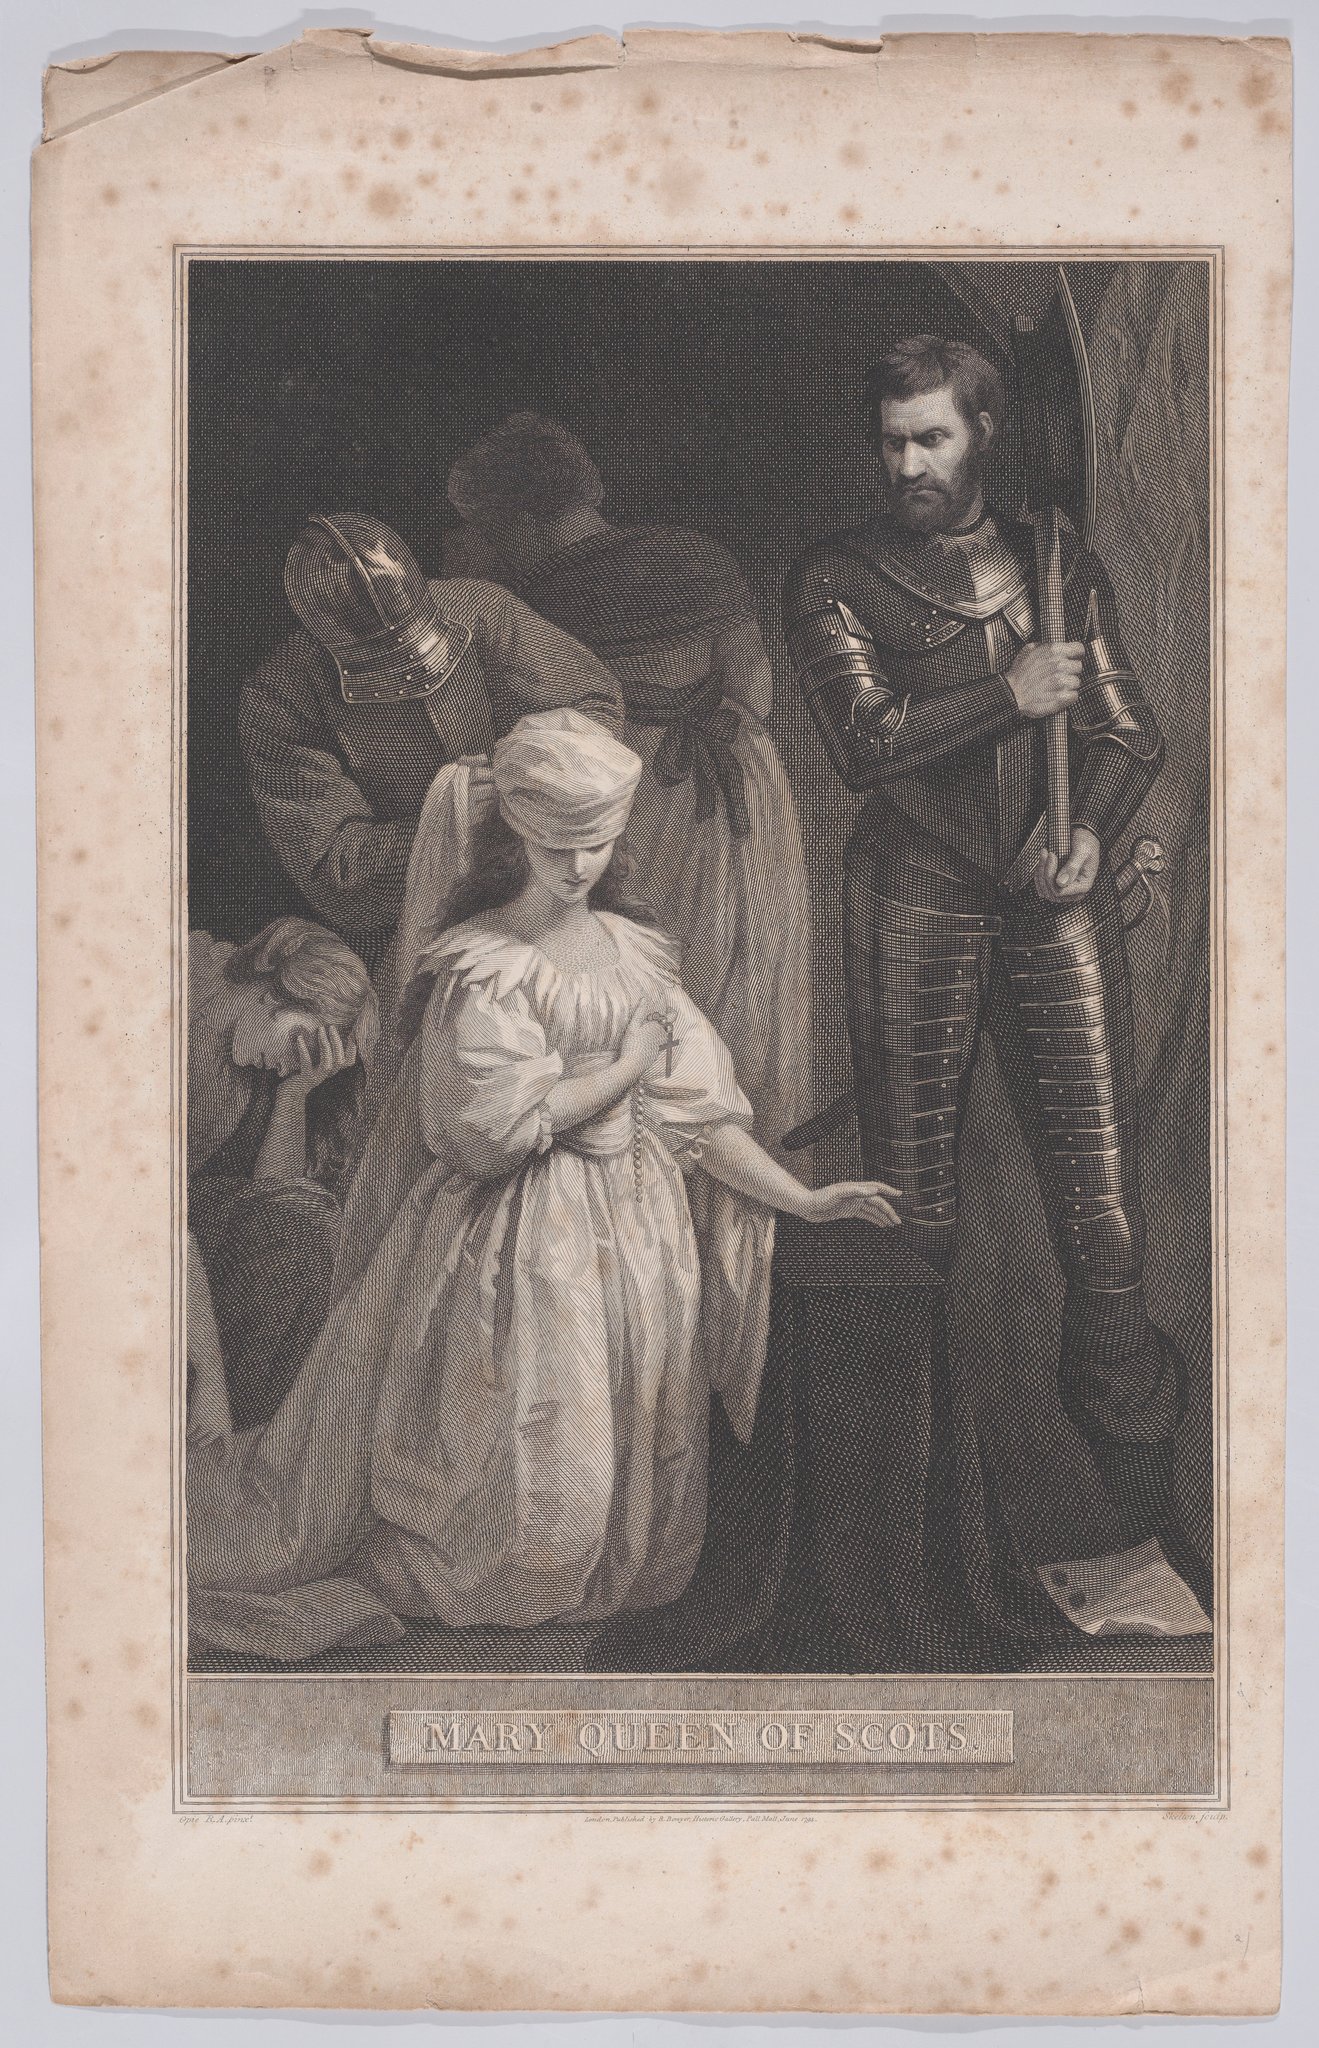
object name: print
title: Mary, Queen of Scots at the execution block (from "The History of England")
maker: david hume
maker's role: author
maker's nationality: british, scottish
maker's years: 1711-1776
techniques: engraving, etching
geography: england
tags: queens,men,women,execution,mary queen of scots